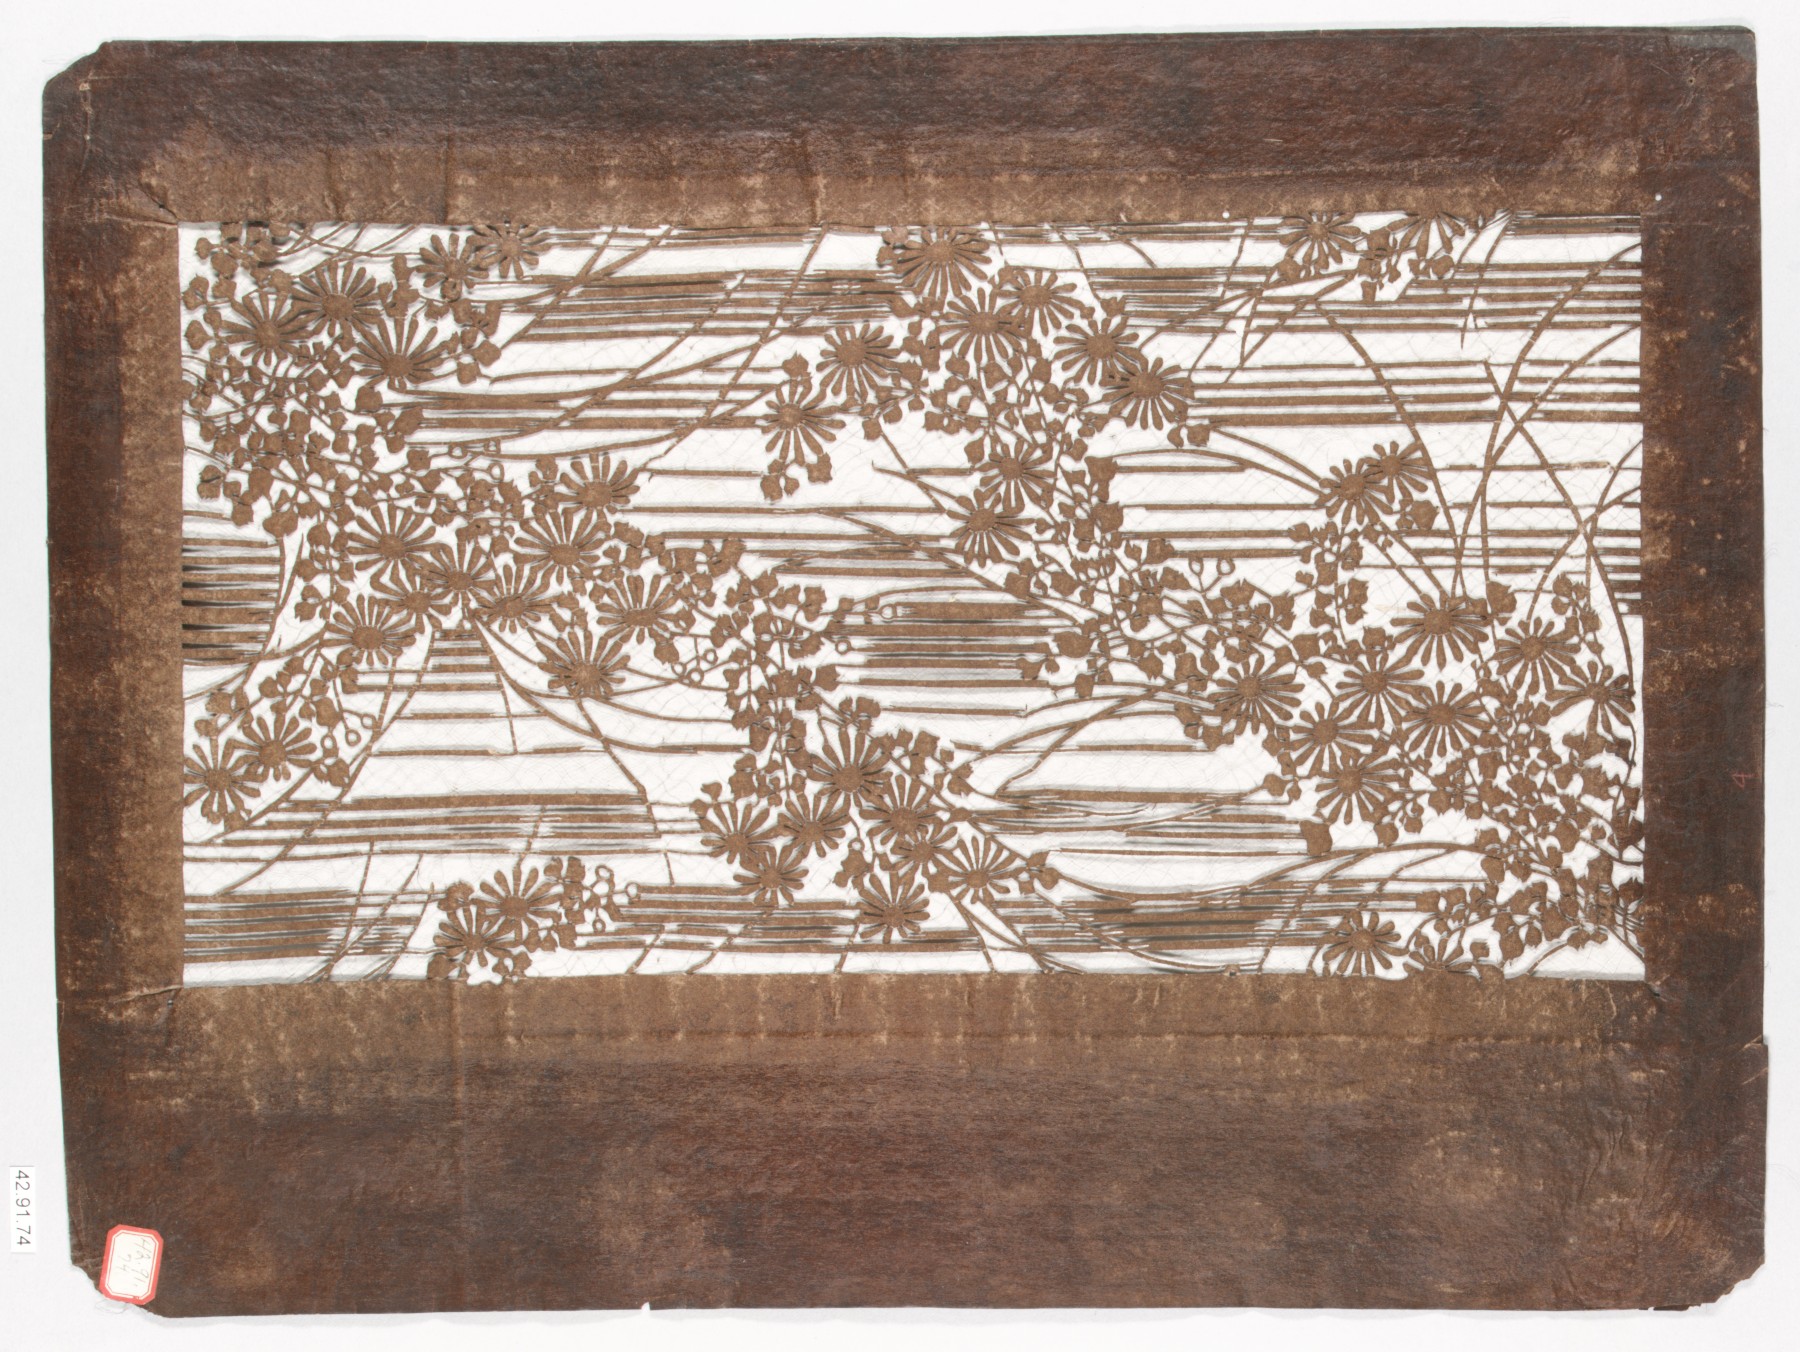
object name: stencil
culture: japanese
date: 1801-1900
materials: paper, silk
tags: plants